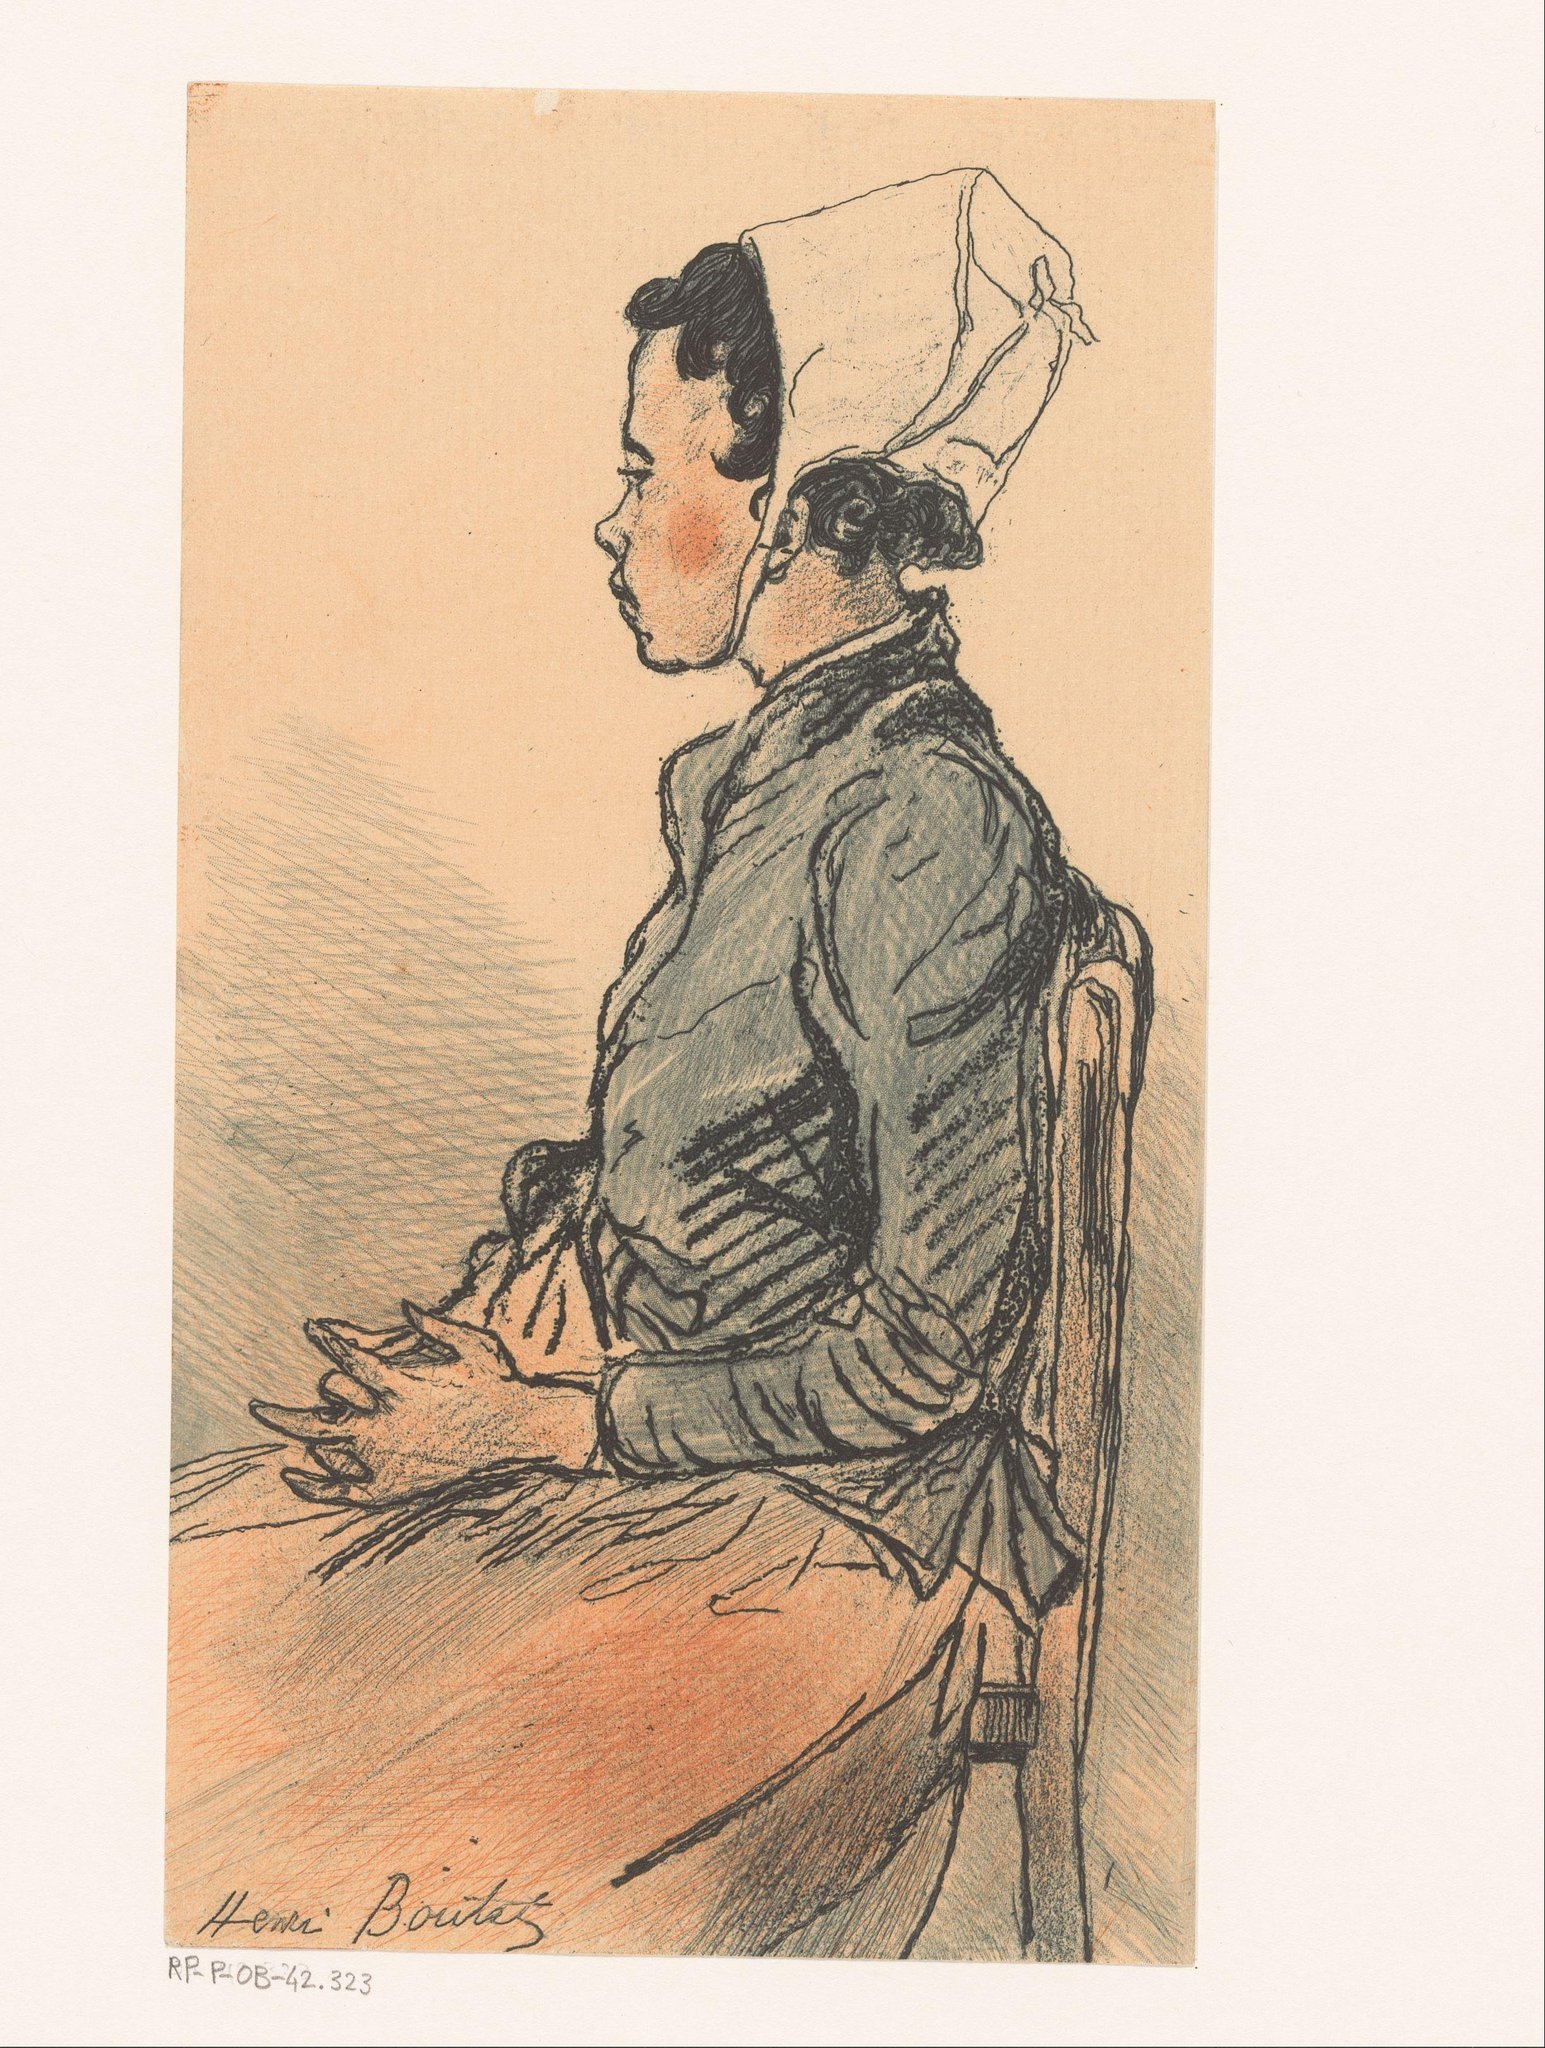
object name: print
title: Zijaanzicht van een jonge vrouw op een stoel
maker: henri boutet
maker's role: draughtsman, print maker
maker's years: 1851-1919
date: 1861-1919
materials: paper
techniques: etching, roulette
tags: adolescent, young woman, maiden, sitting figure, chair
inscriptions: collector's mark: Lugt 2228